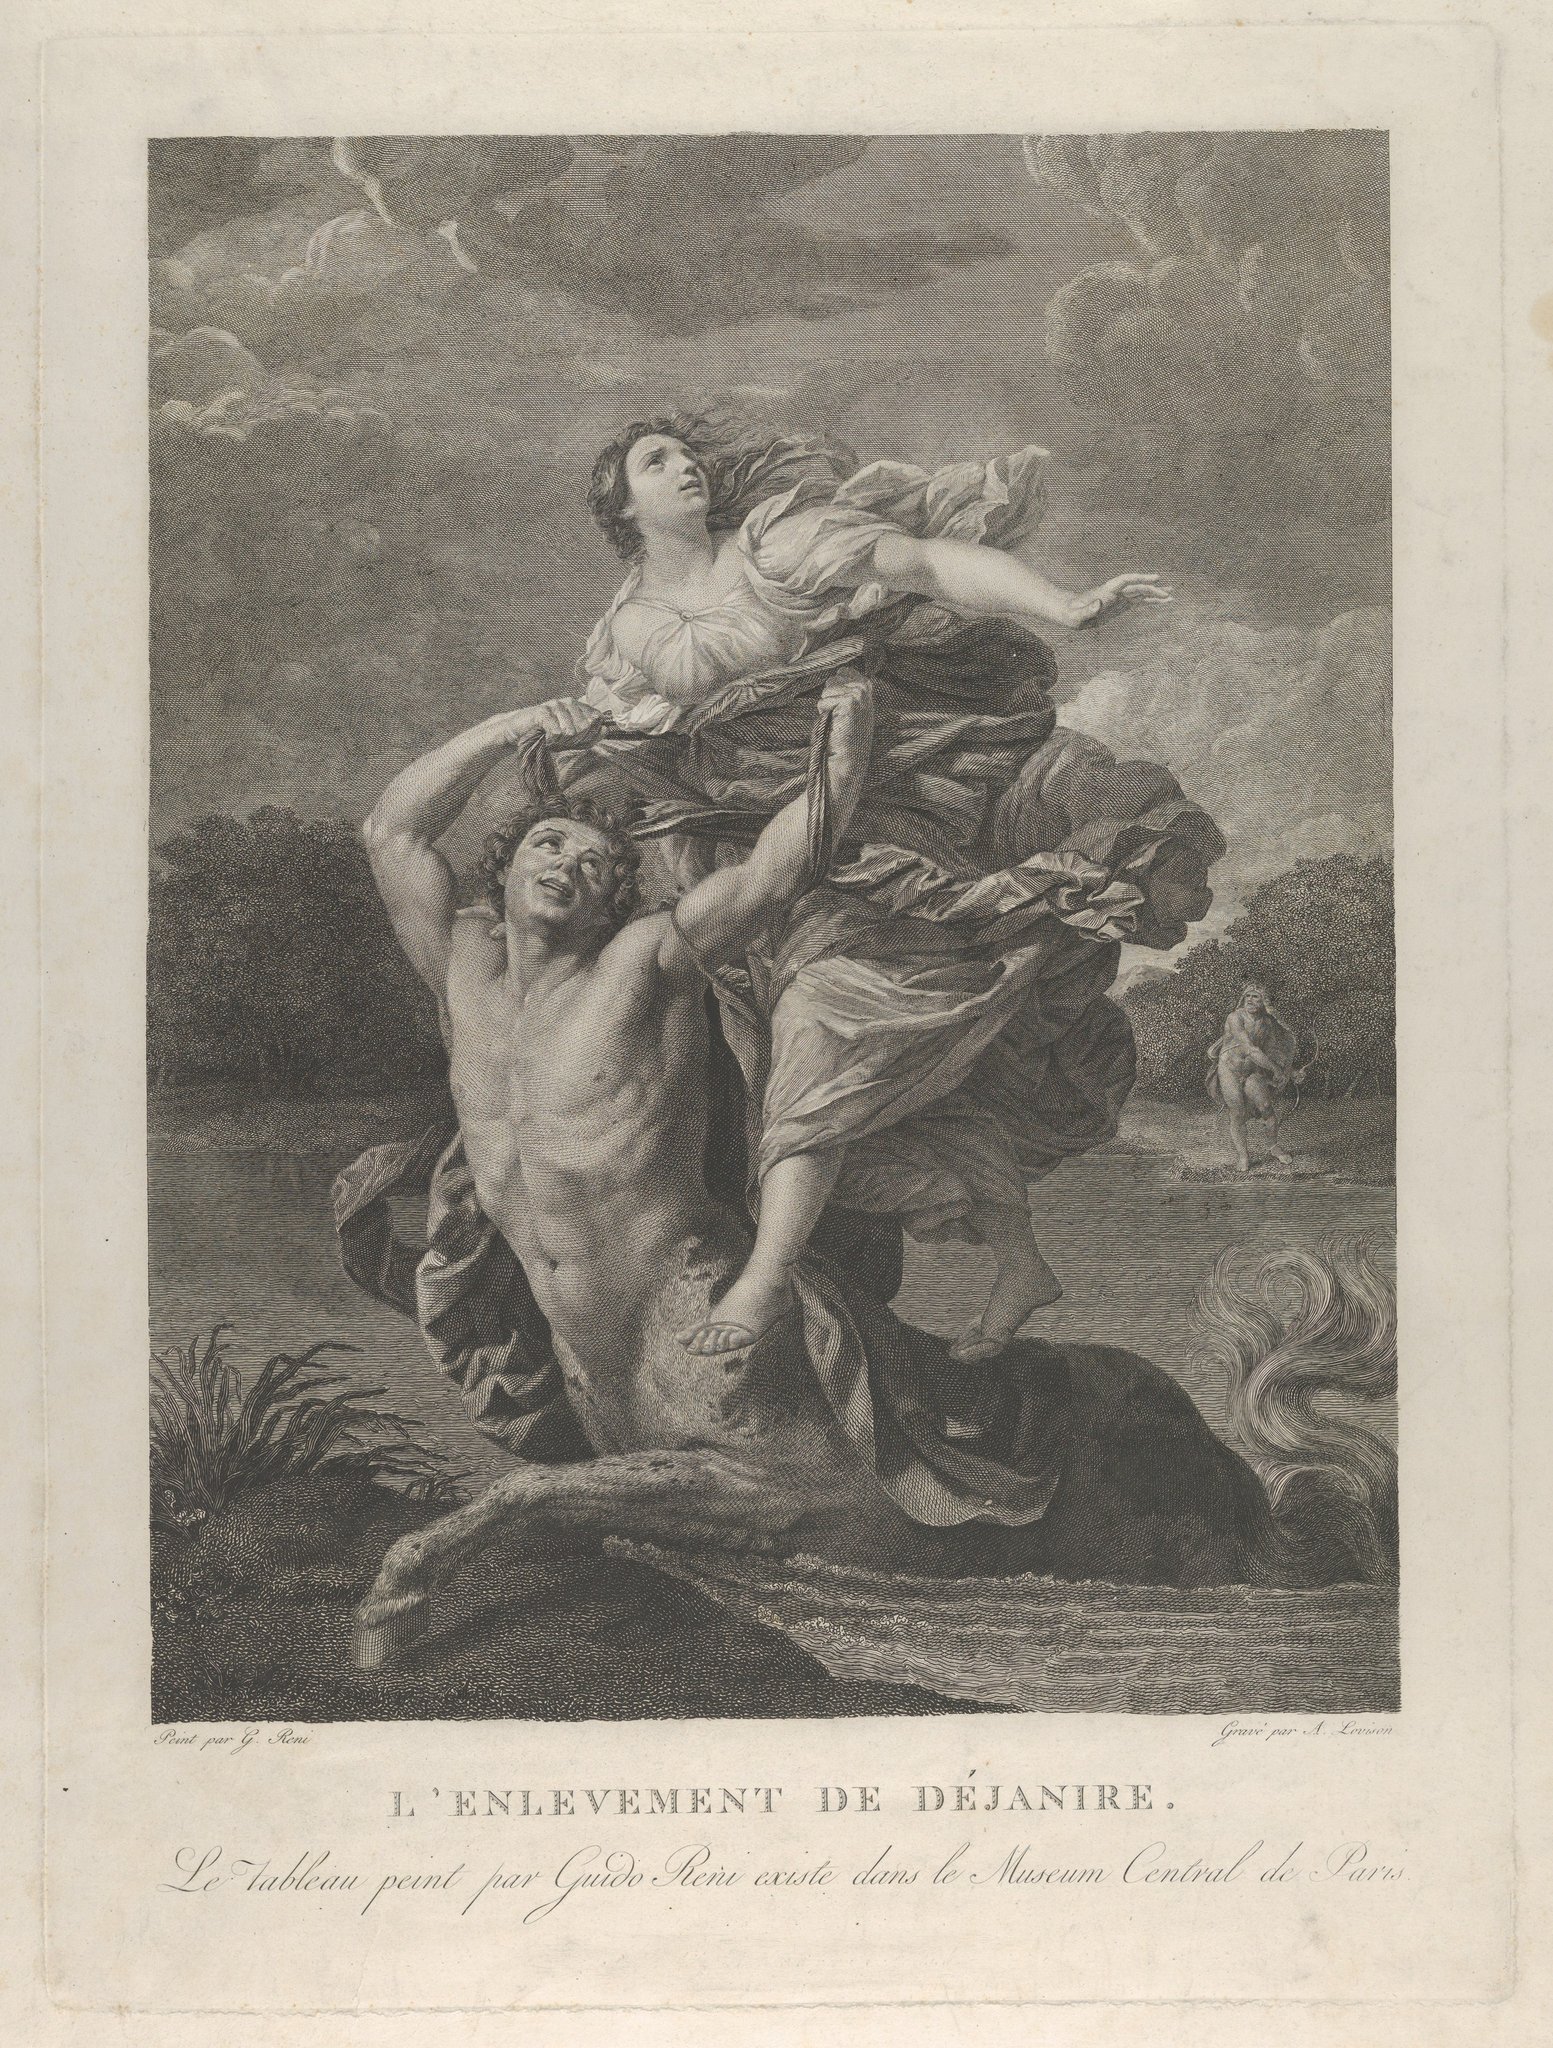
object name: print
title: Dejanira being abducted by the centaur Nessos, a man with bow and arrow at right, after Reni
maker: a. lovison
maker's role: artist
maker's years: 1750-1900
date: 1800-1840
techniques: engraving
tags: women,centaurs